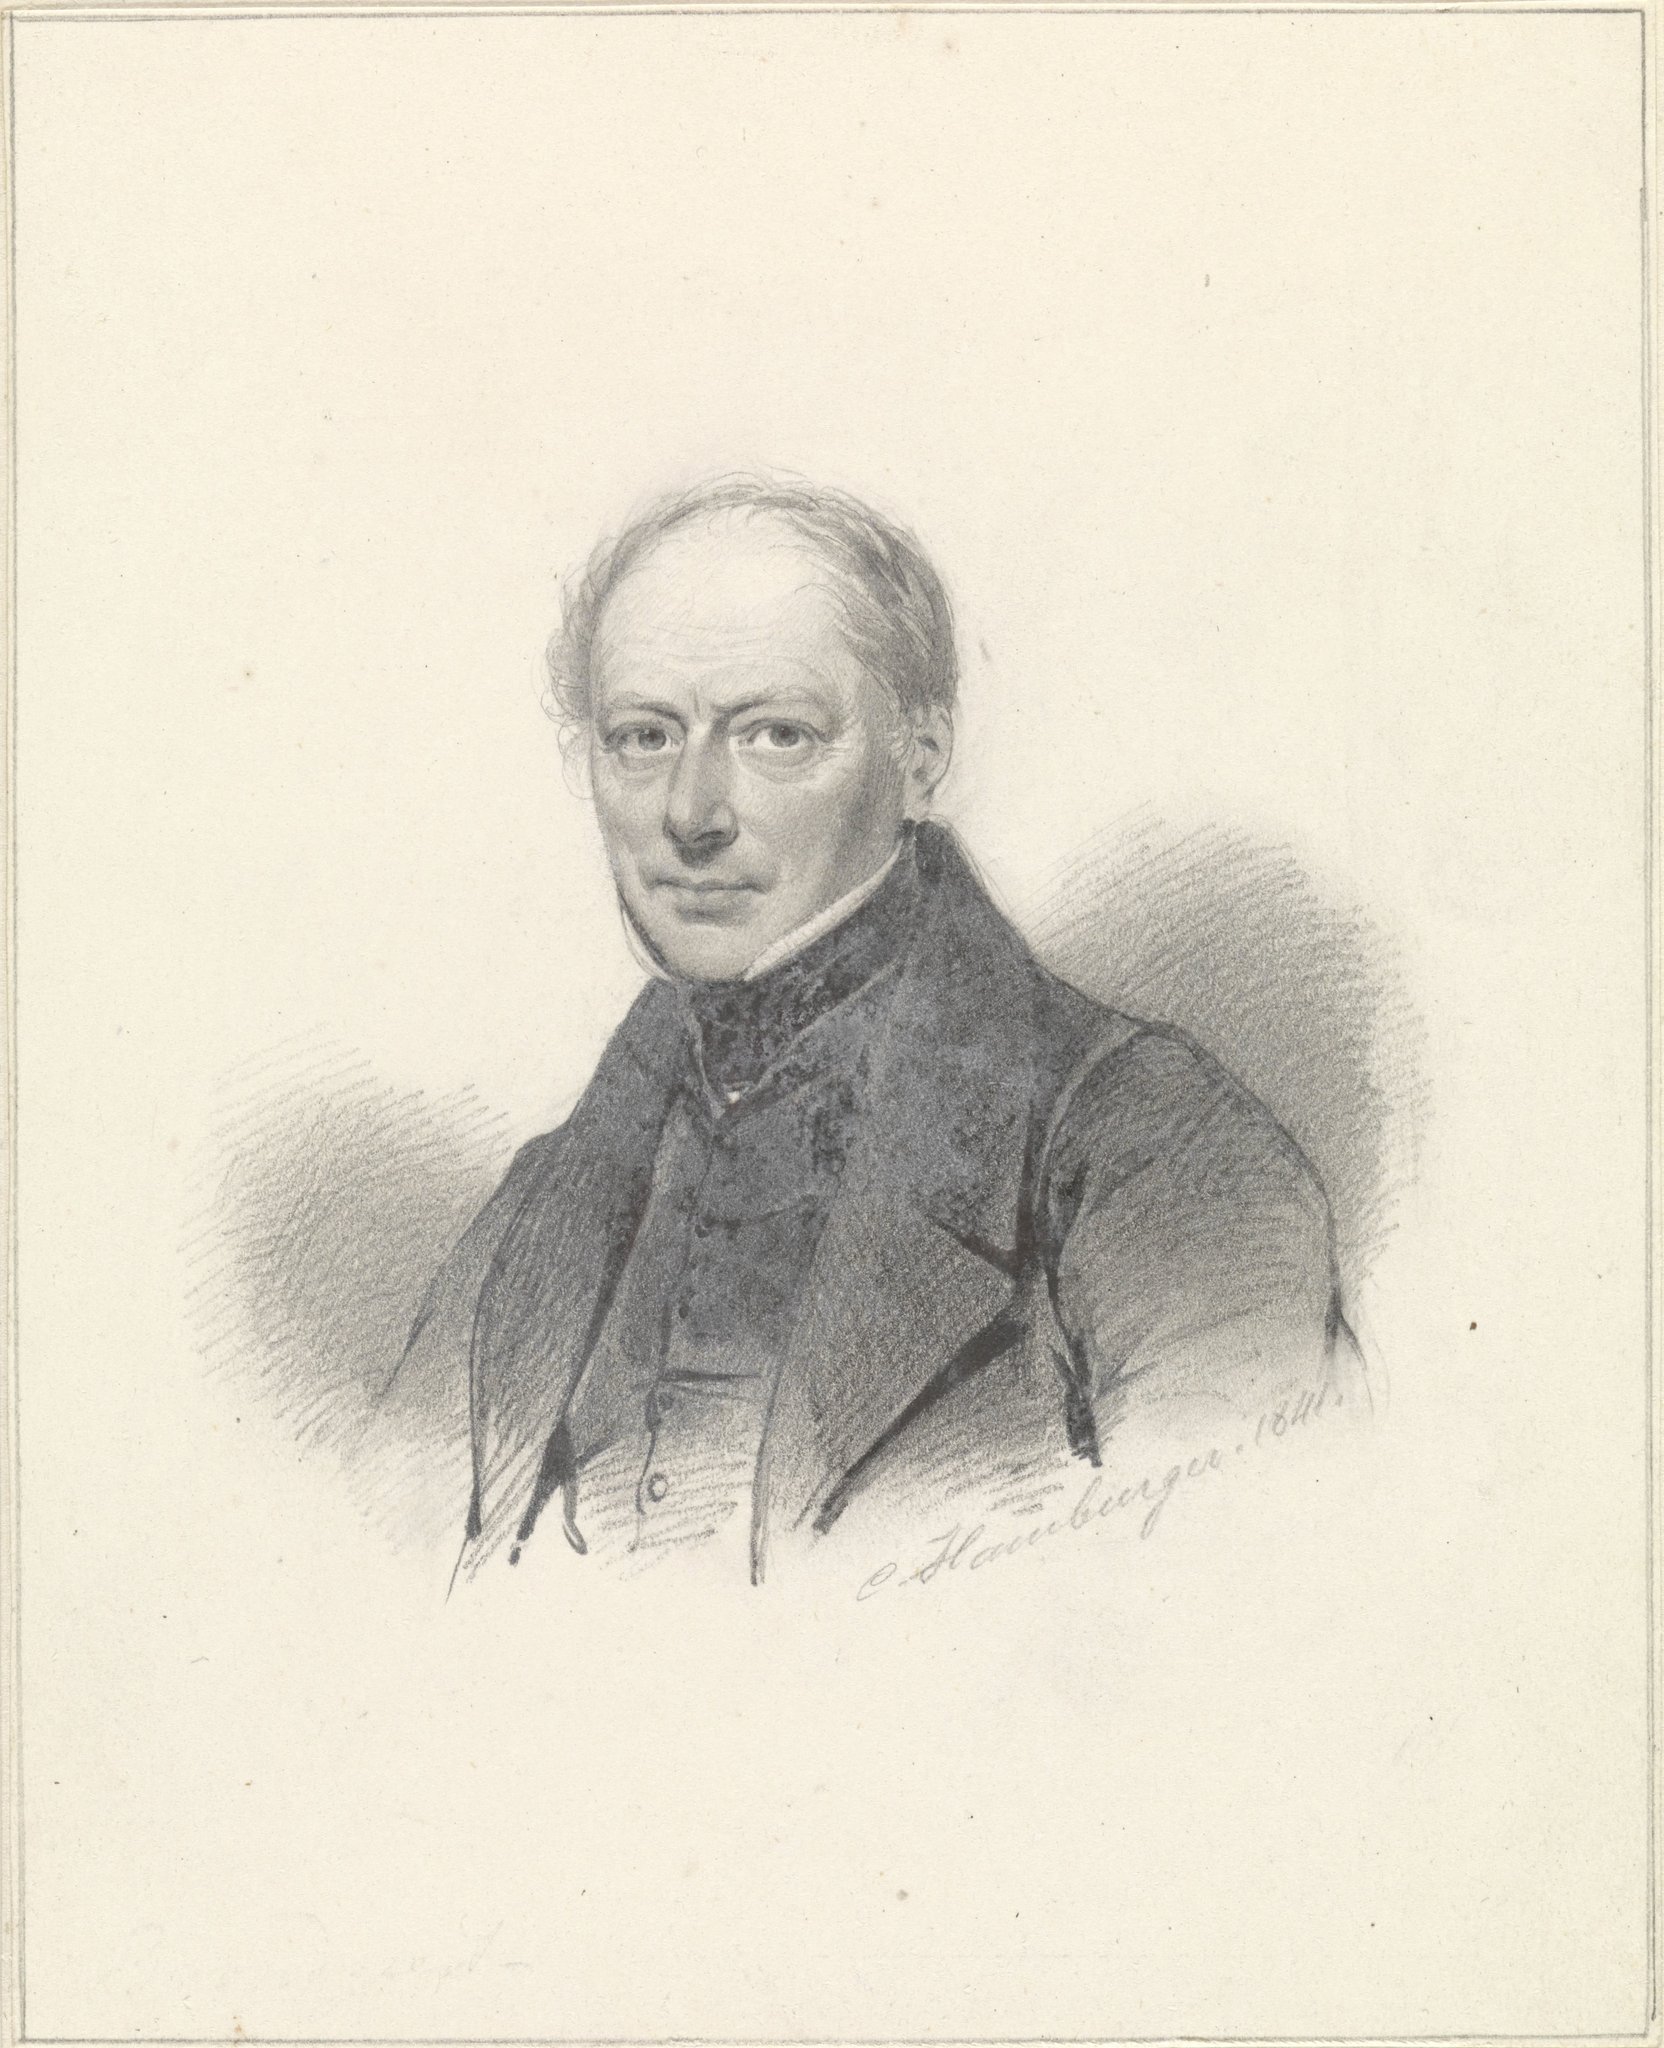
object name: design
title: Portret van Albertus Brondgeest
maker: coenraad hamburger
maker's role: draughtsman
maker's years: 1809-1891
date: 1841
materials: paper, pencil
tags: amsterdam, print maker, albertus brondgeest, historical persons, portrait, self-portrait of painter, portrait, self-portrait of artist, portrait, self-portrait of draughtsman